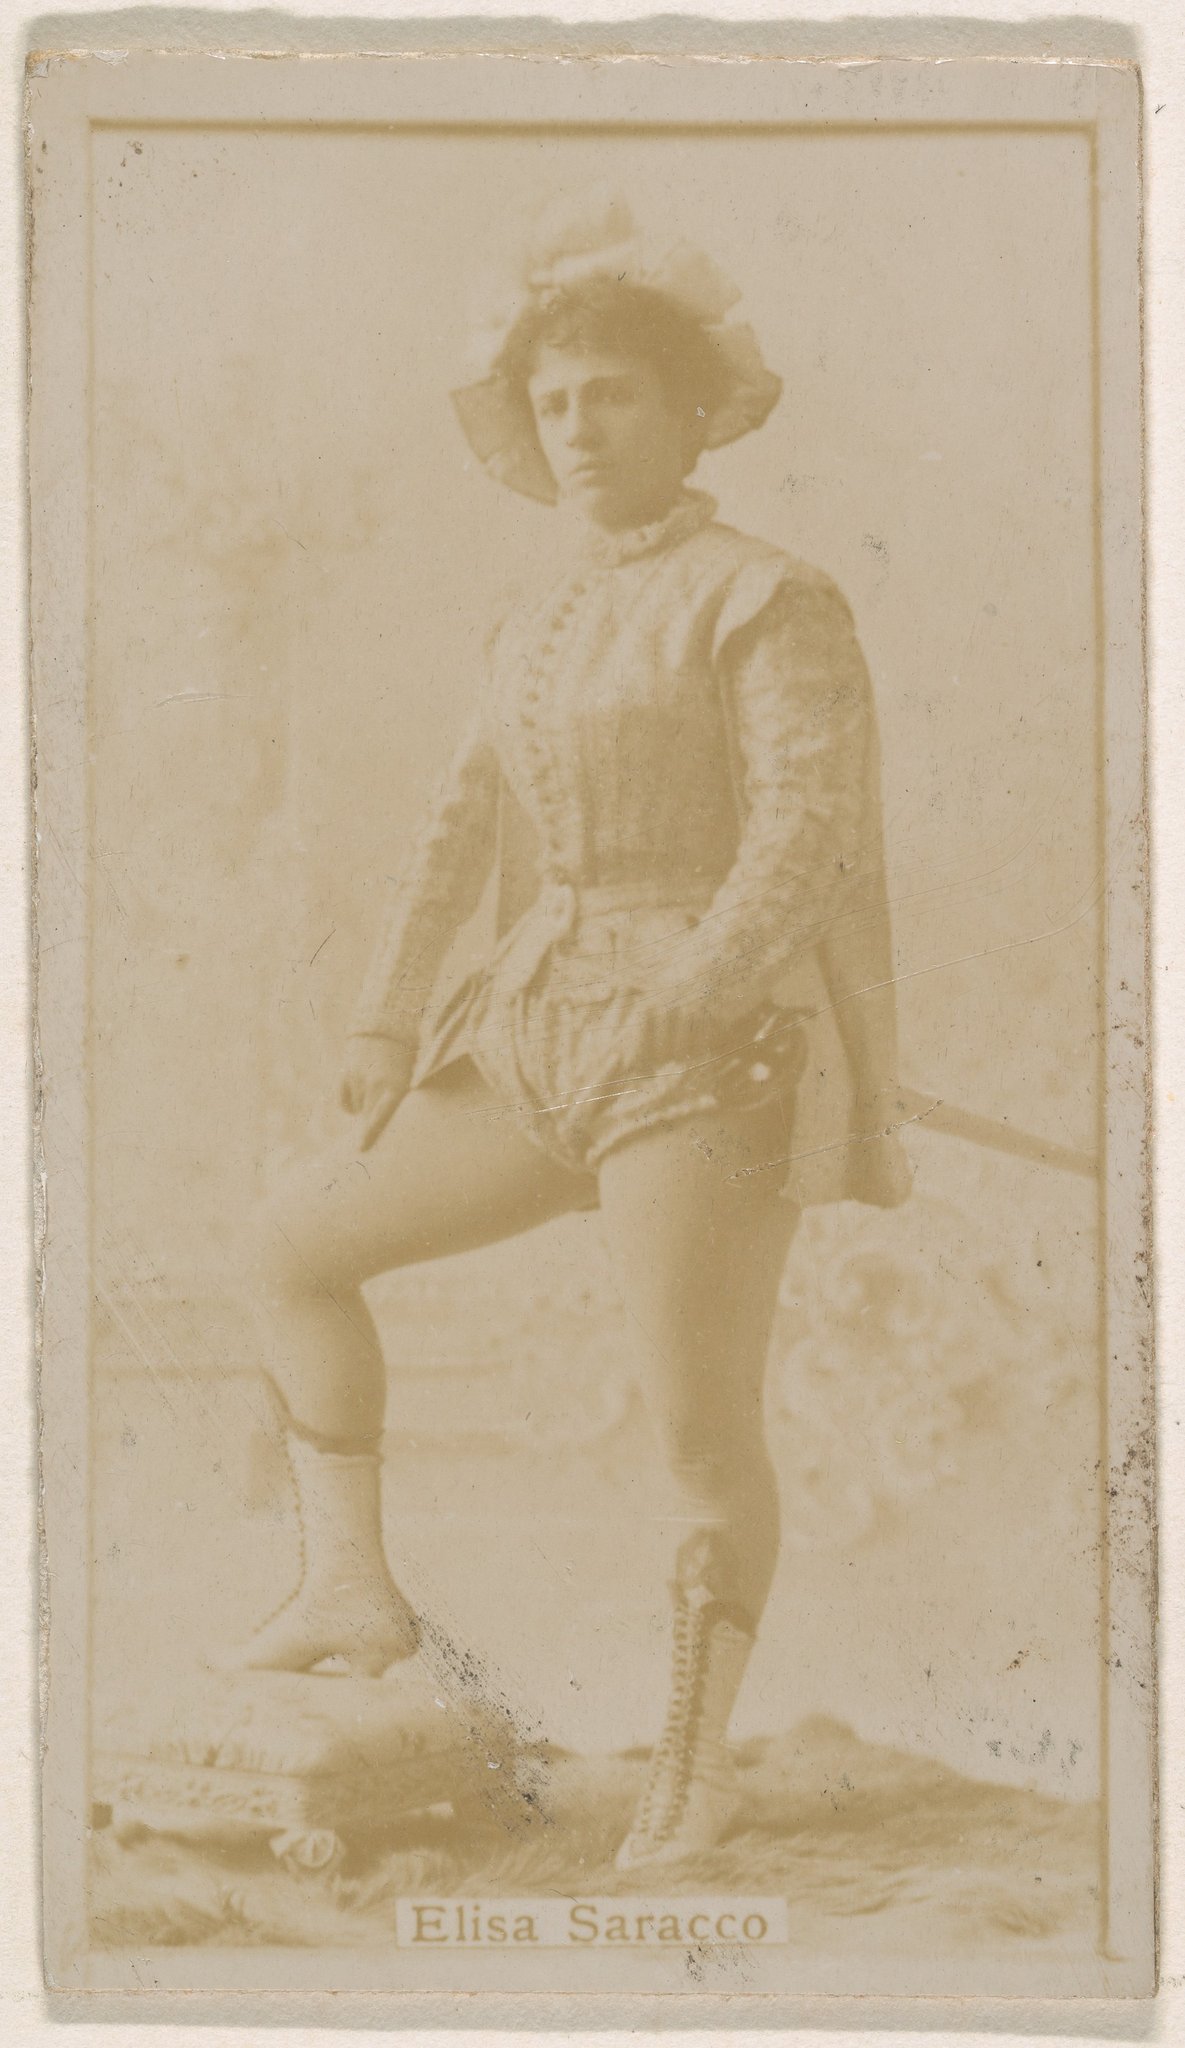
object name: photograph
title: Mlle. Elisa Saracco, from the Actresses series (N245) issued by Kinney Brothers to promote Sweet Caporal Cigarettes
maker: kinney brothers tobacco company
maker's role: publisher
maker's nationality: american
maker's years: 1869-2011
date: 1890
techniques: albumen silver print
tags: portraits,women,actresses